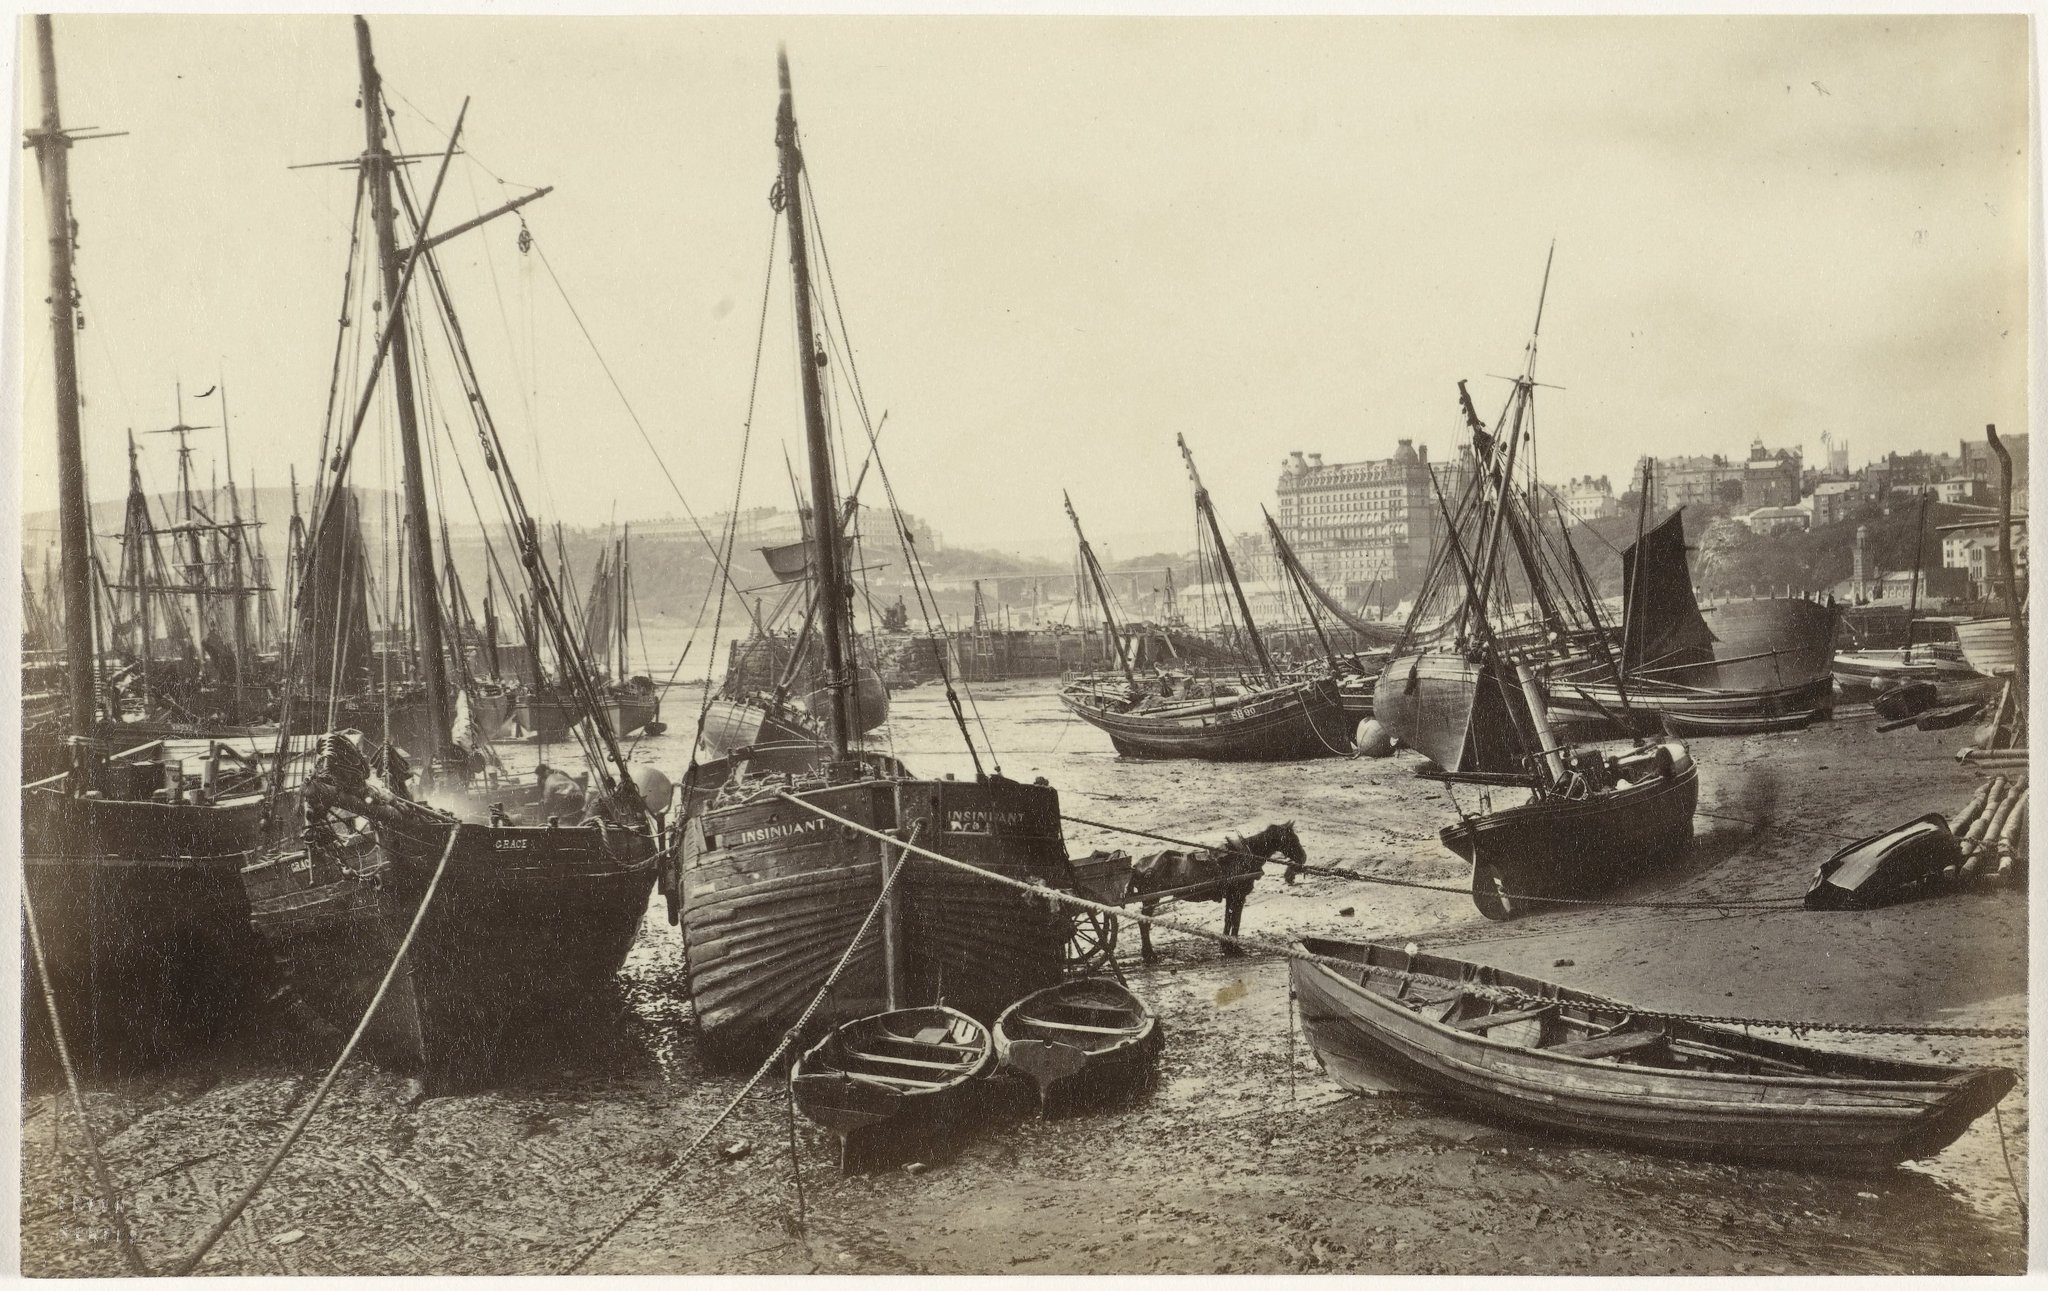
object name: photograph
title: Frith's Series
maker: francis frith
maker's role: publisher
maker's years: 1822-1898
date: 1867-1898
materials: paper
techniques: albumen print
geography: great britain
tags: harbour, ships (in general) - cc - more than one ship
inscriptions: number: ‘132/ 303/ 10748.’